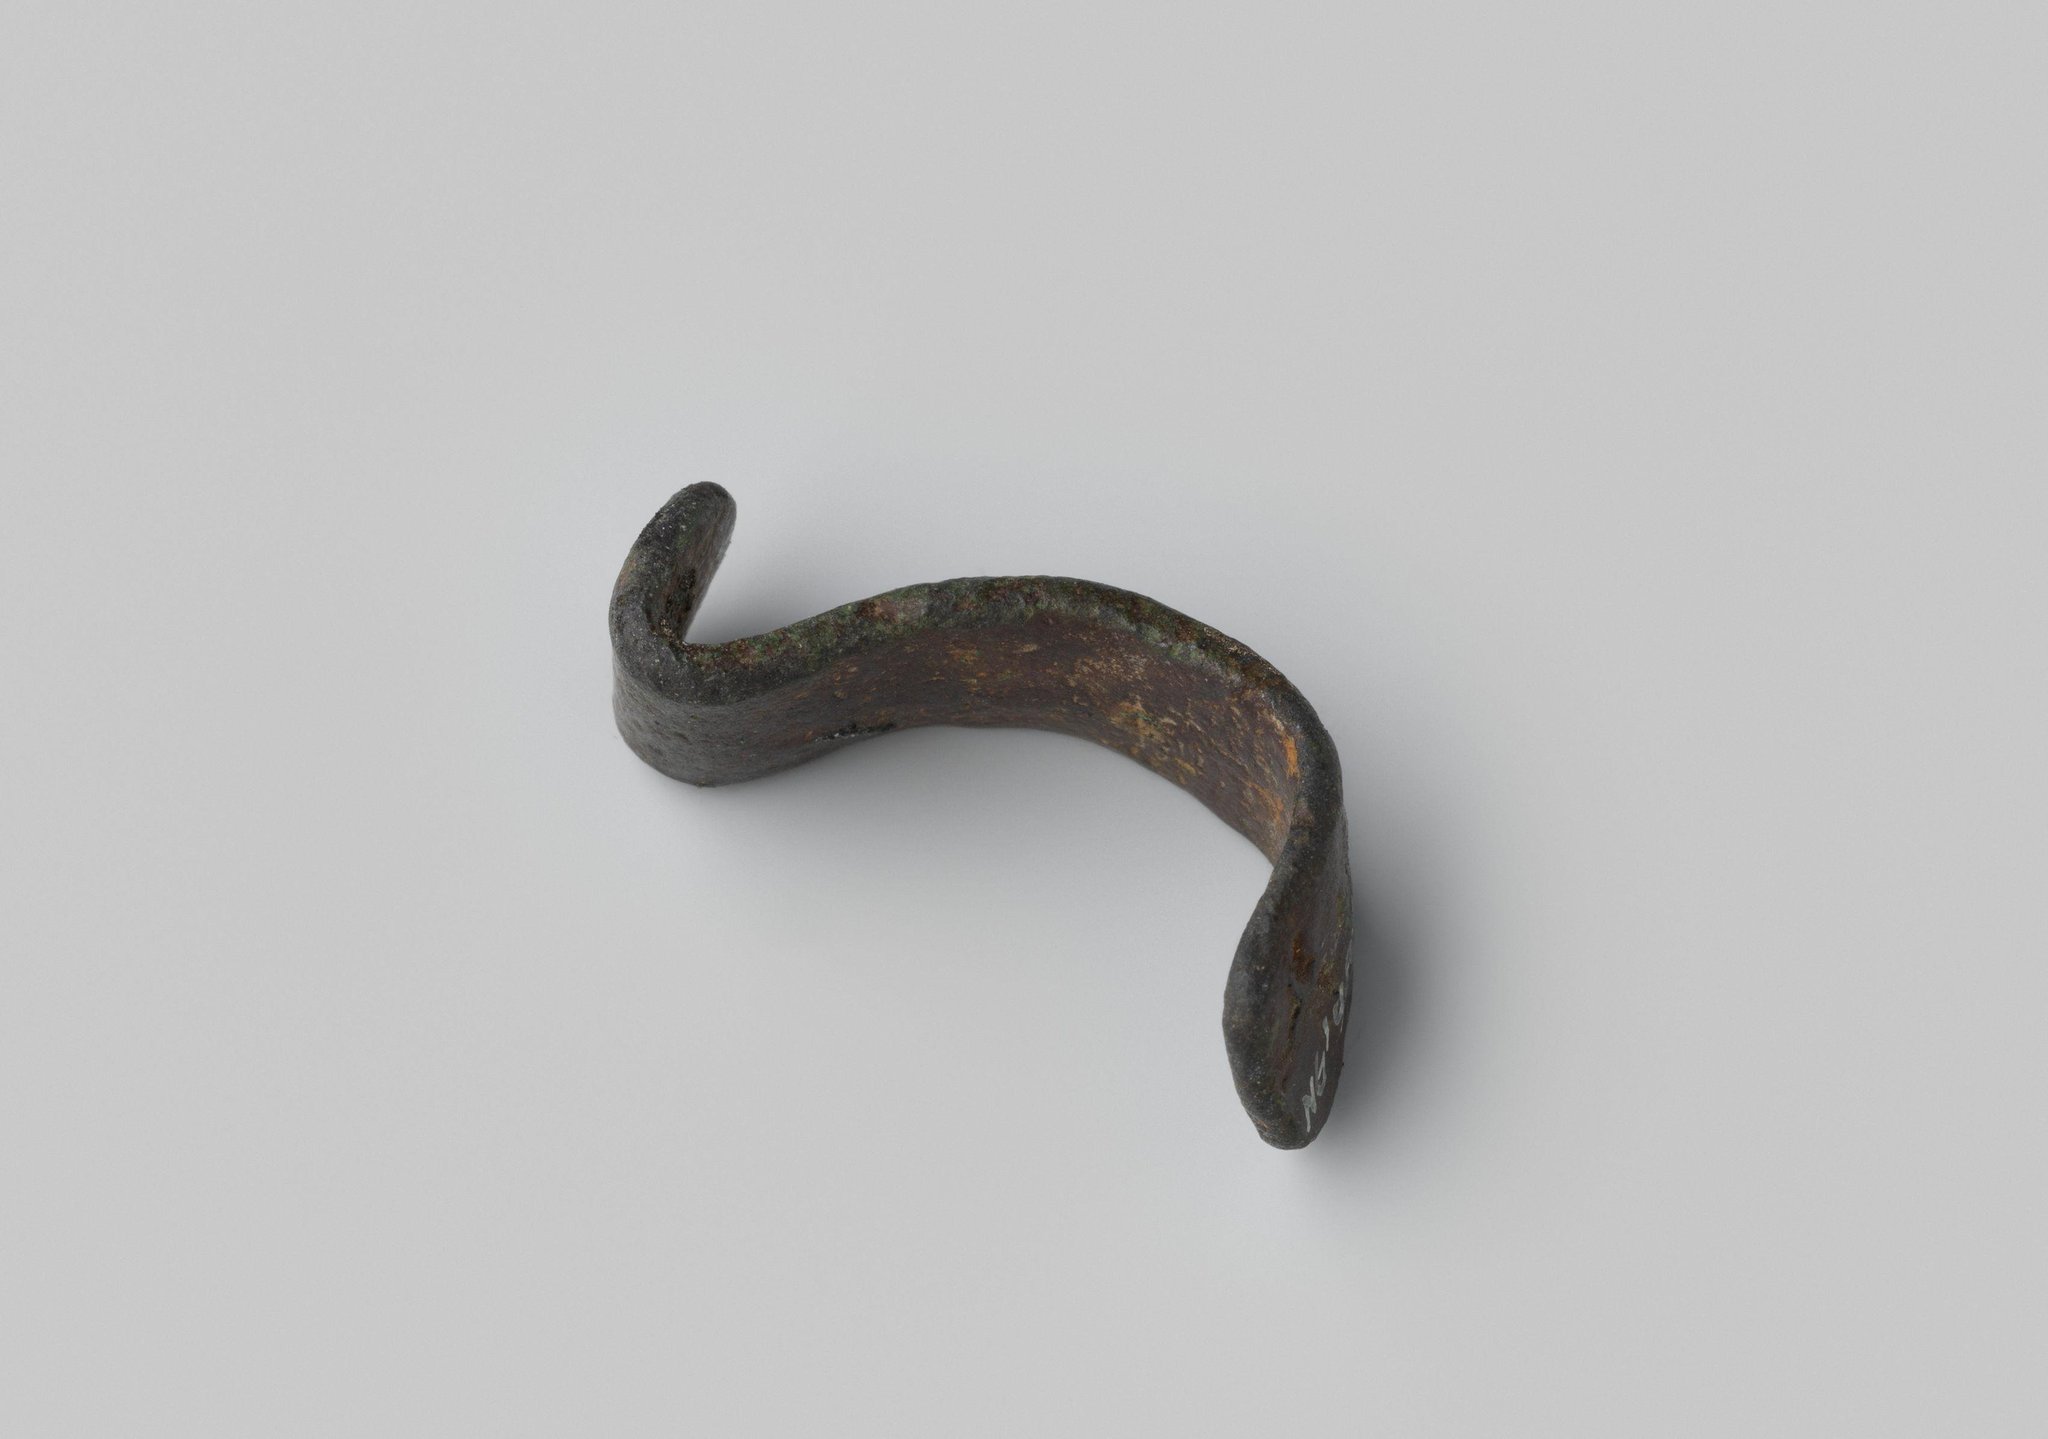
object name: klamp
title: Klamp afkomstig uit het wrak van de Oost-Indiëvaarder Hollandia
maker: Anonymous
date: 1700-1743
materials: copper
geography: netherlands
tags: verenigde oostindische compagnie, hollandia (schip)